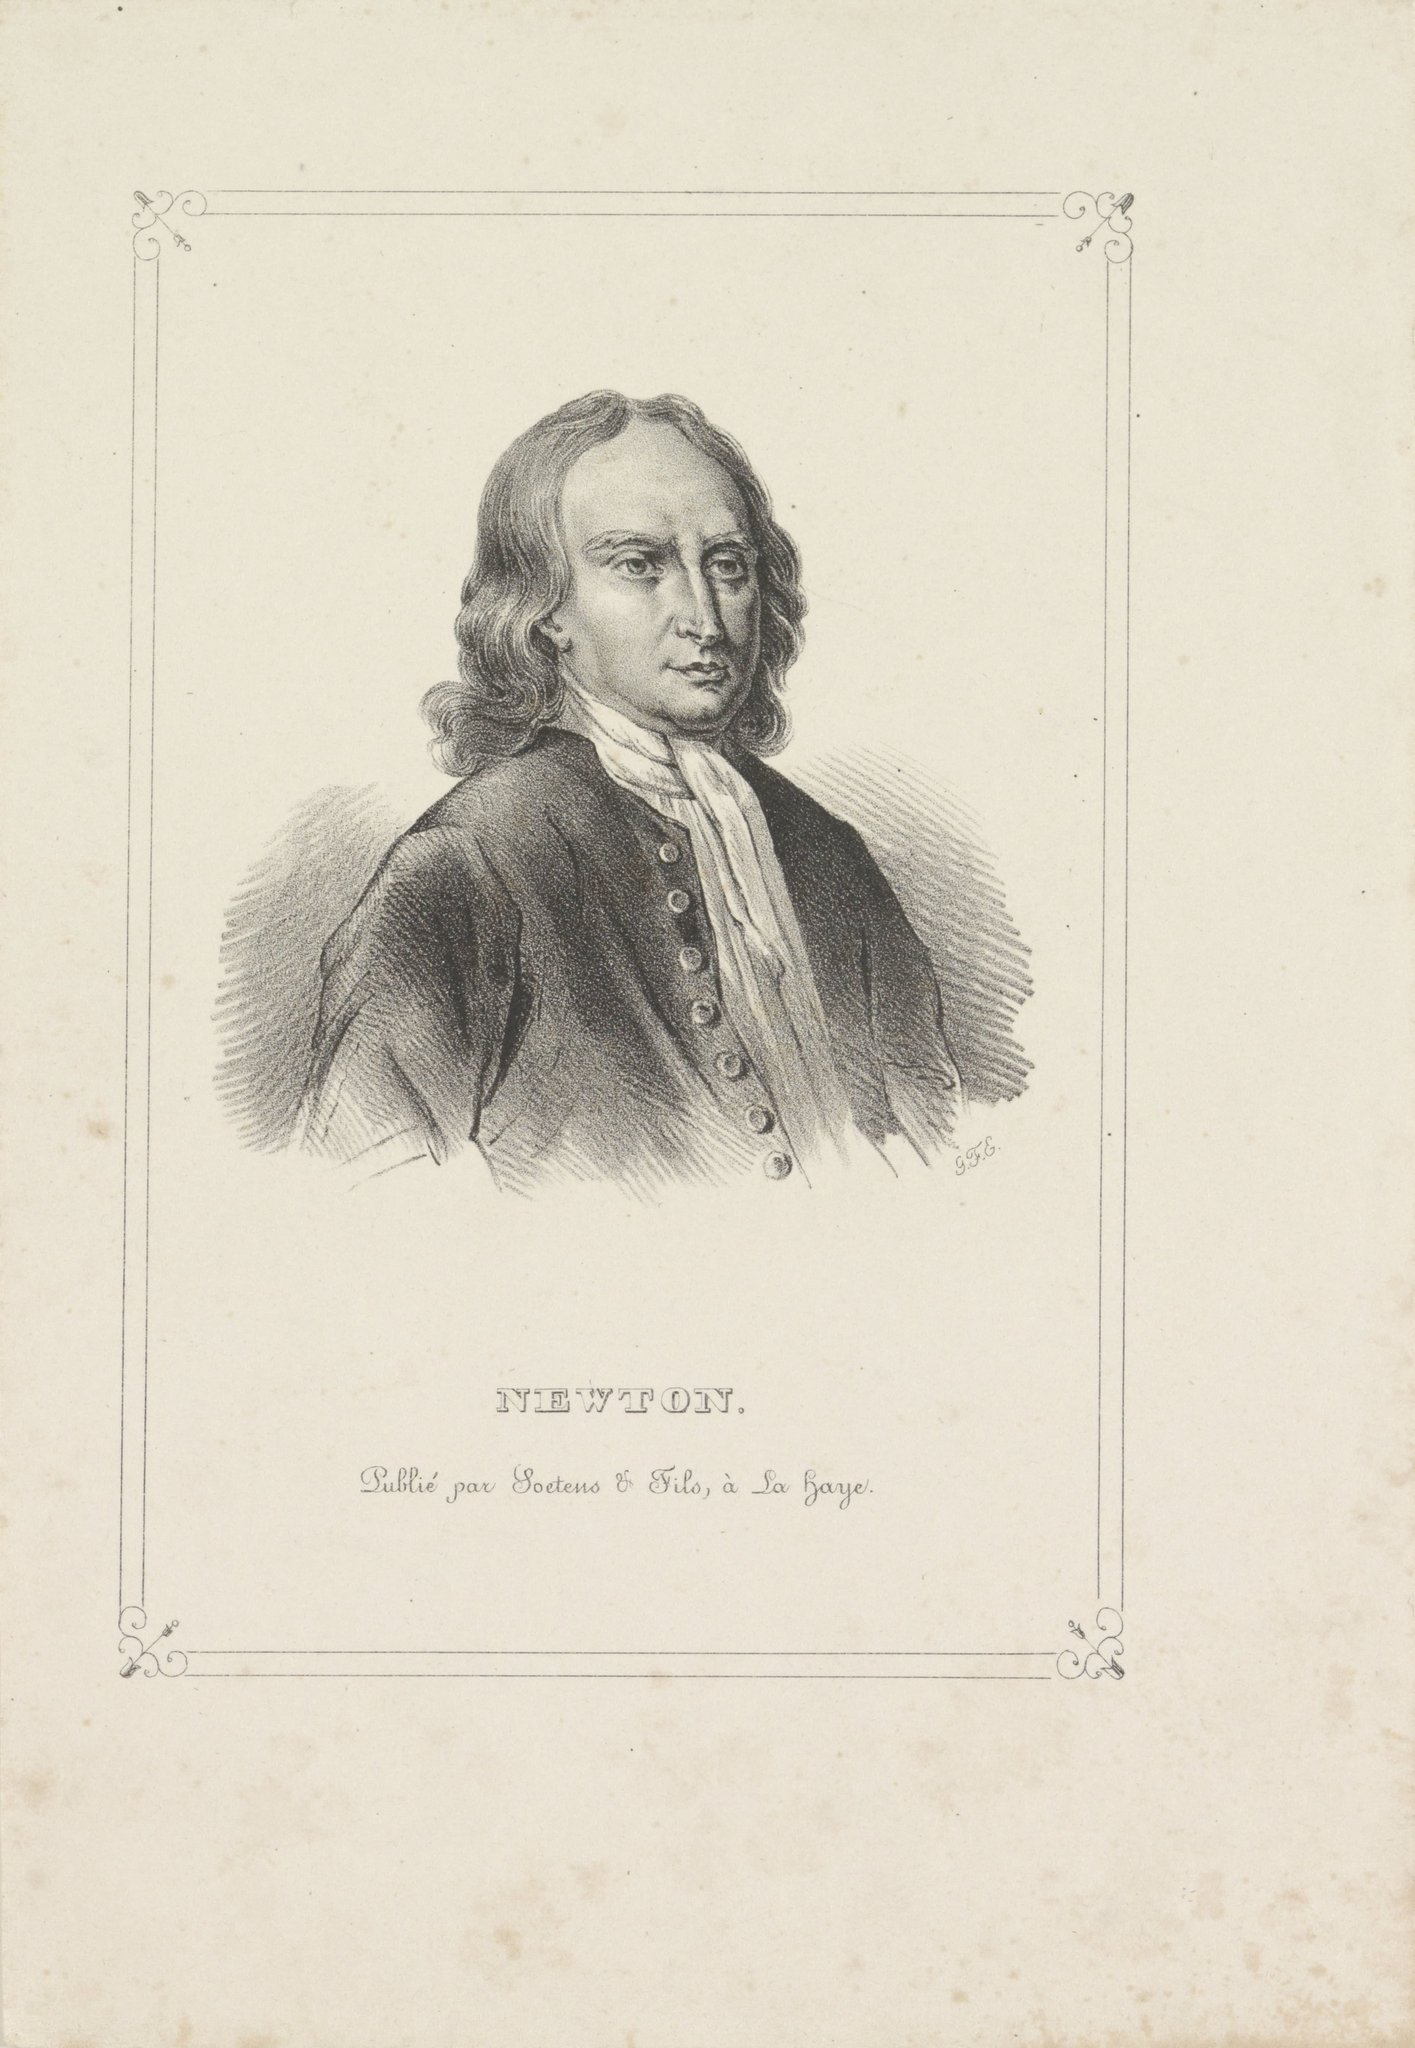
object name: print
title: Portret van Isaac Newton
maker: gerhardus fredericus eilbracht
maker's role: draughtsman, print maker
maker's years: 1816-1854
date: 1837-1840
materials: paper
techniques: lithograph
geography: the hague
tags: london, physicist, historical persons (+ (full) bust portrait)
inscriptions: collector's mark: Lugt 2228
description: Deze prent maakte deel uit van een serie uitgegeven door Soetens et Fils omstreeks 1838, opgedragen aan de Prins van Oranje. In de 'Prospectus en Inteekenlijst' stond vermeld dat het zal bestaan uit een onbepaald aantal portretten, waarvan er drie of vier per maand verschijnen. Zie Van Someren.